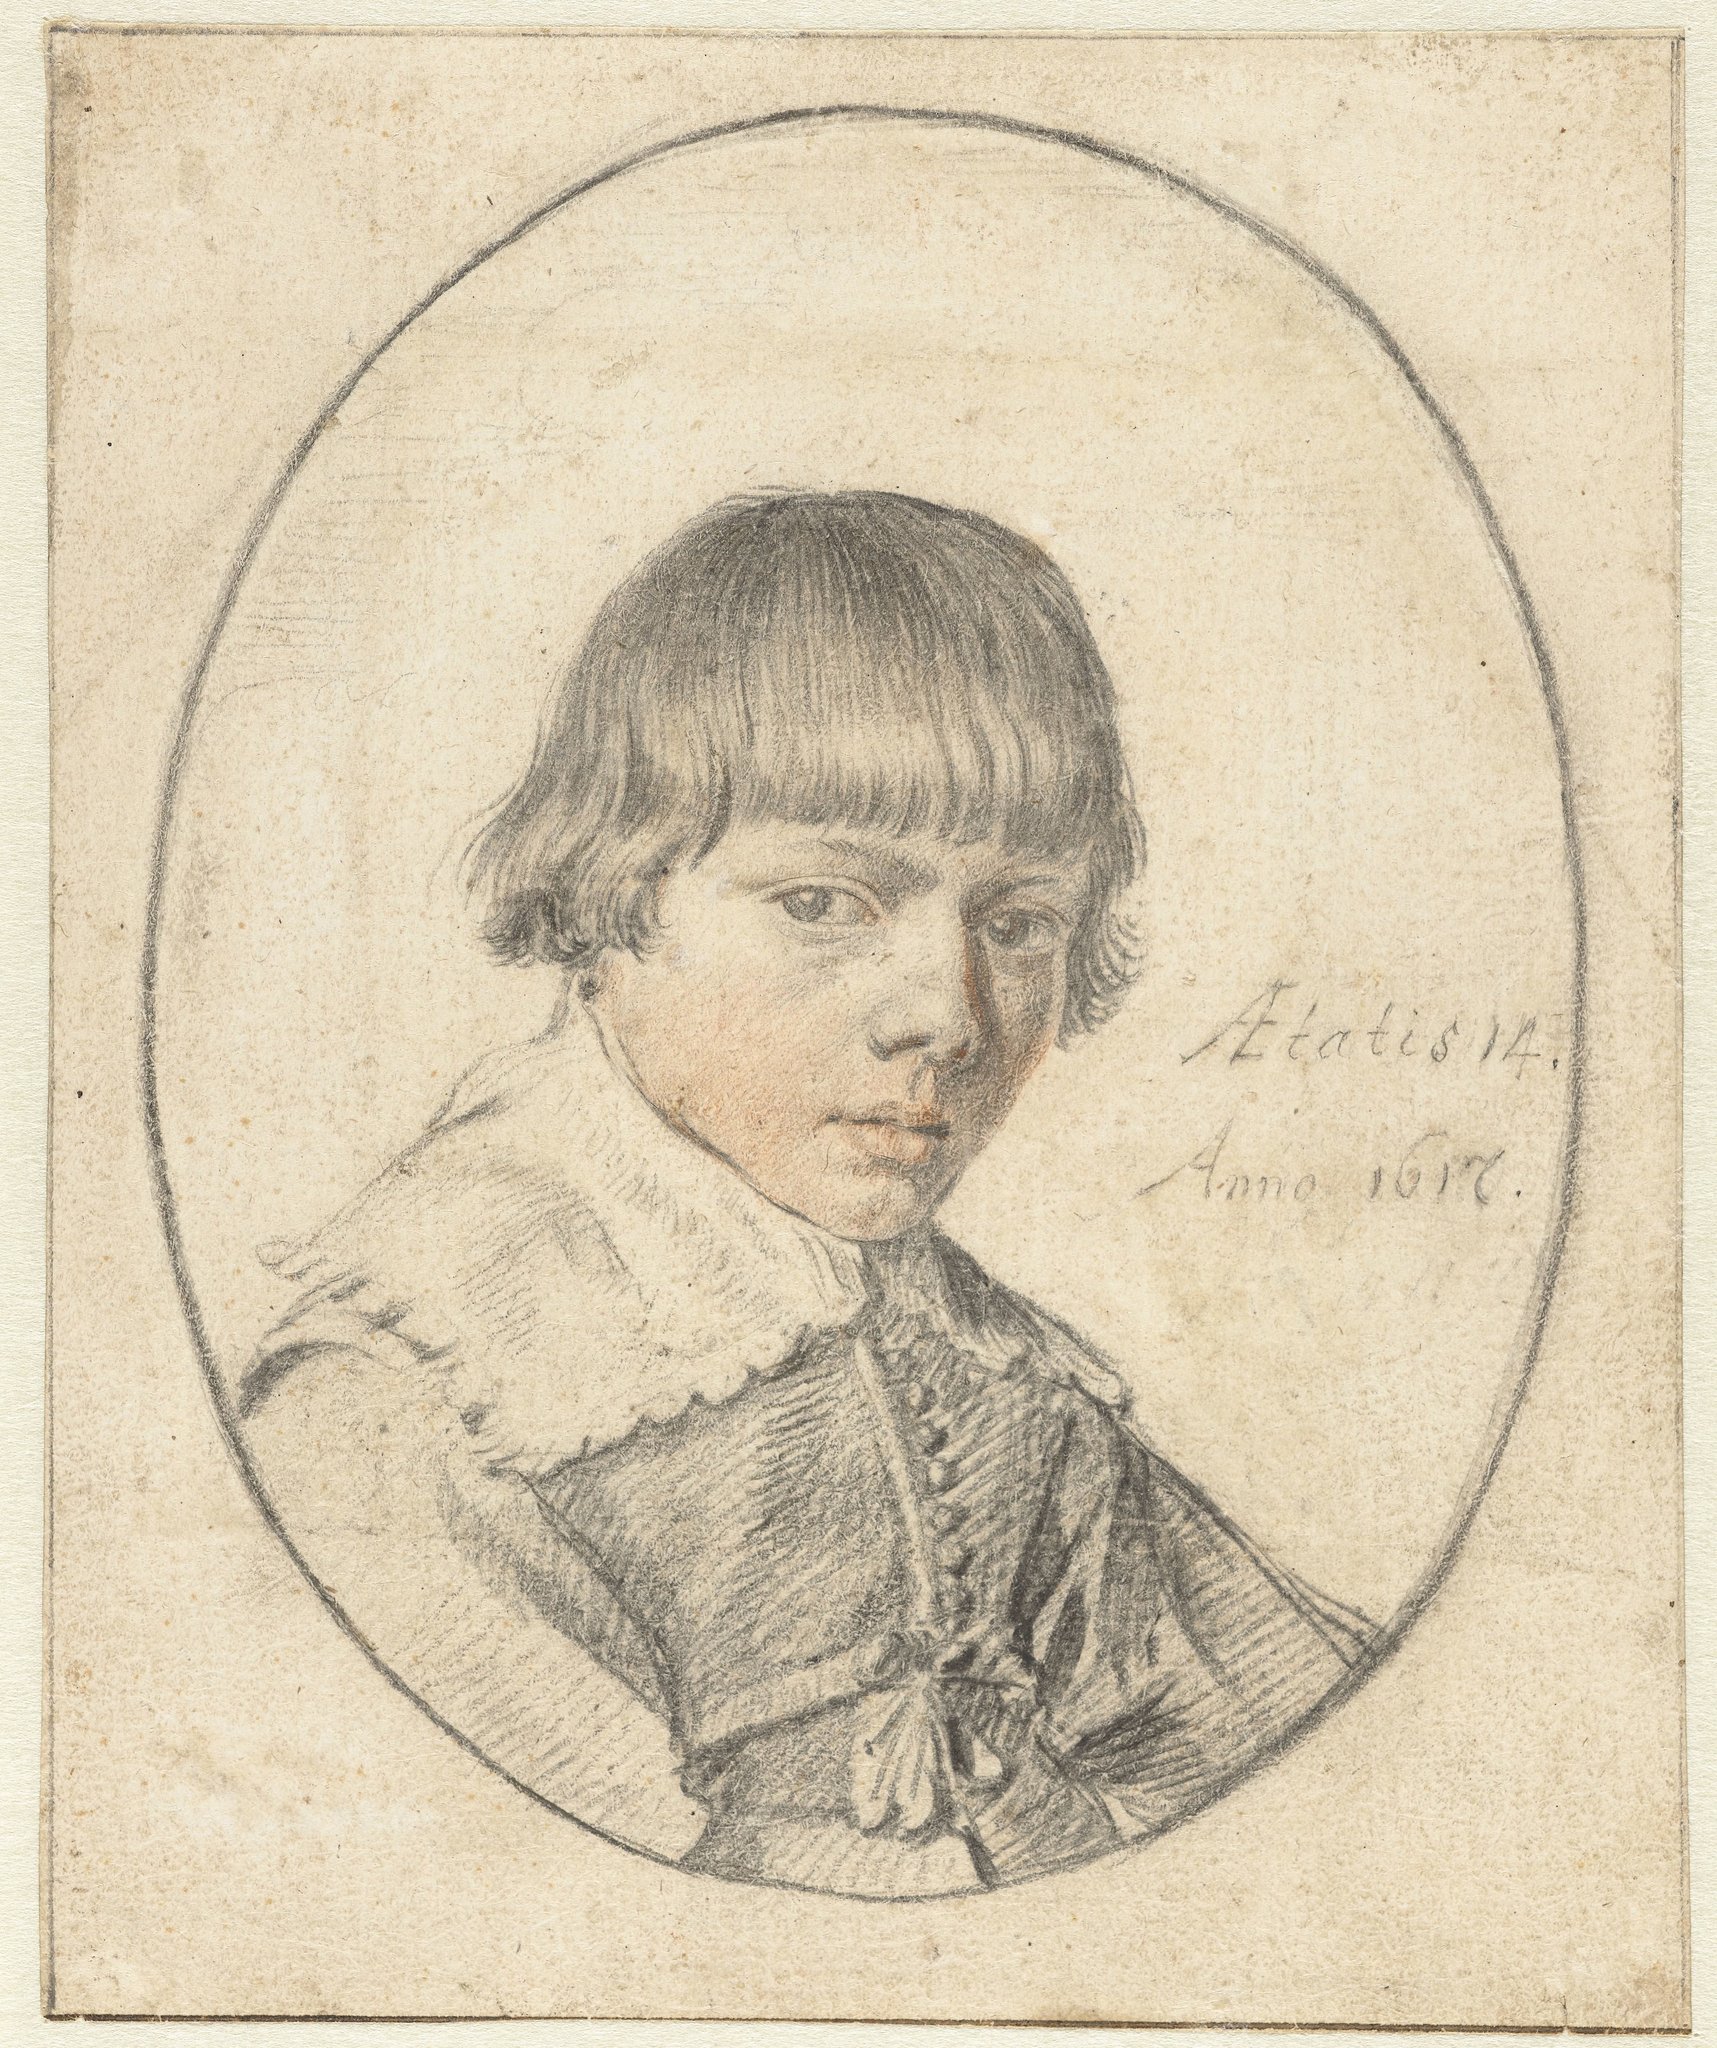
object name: drawing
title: Portret van een 14-jarige jongen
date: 1617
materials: chalk, paper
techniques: brush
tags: youth, adolescent, historical persons not known by name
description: voorheen beschouwd als portret van Jan van Bronckhorst, ter halver lijve naar rechts, in ovaal.